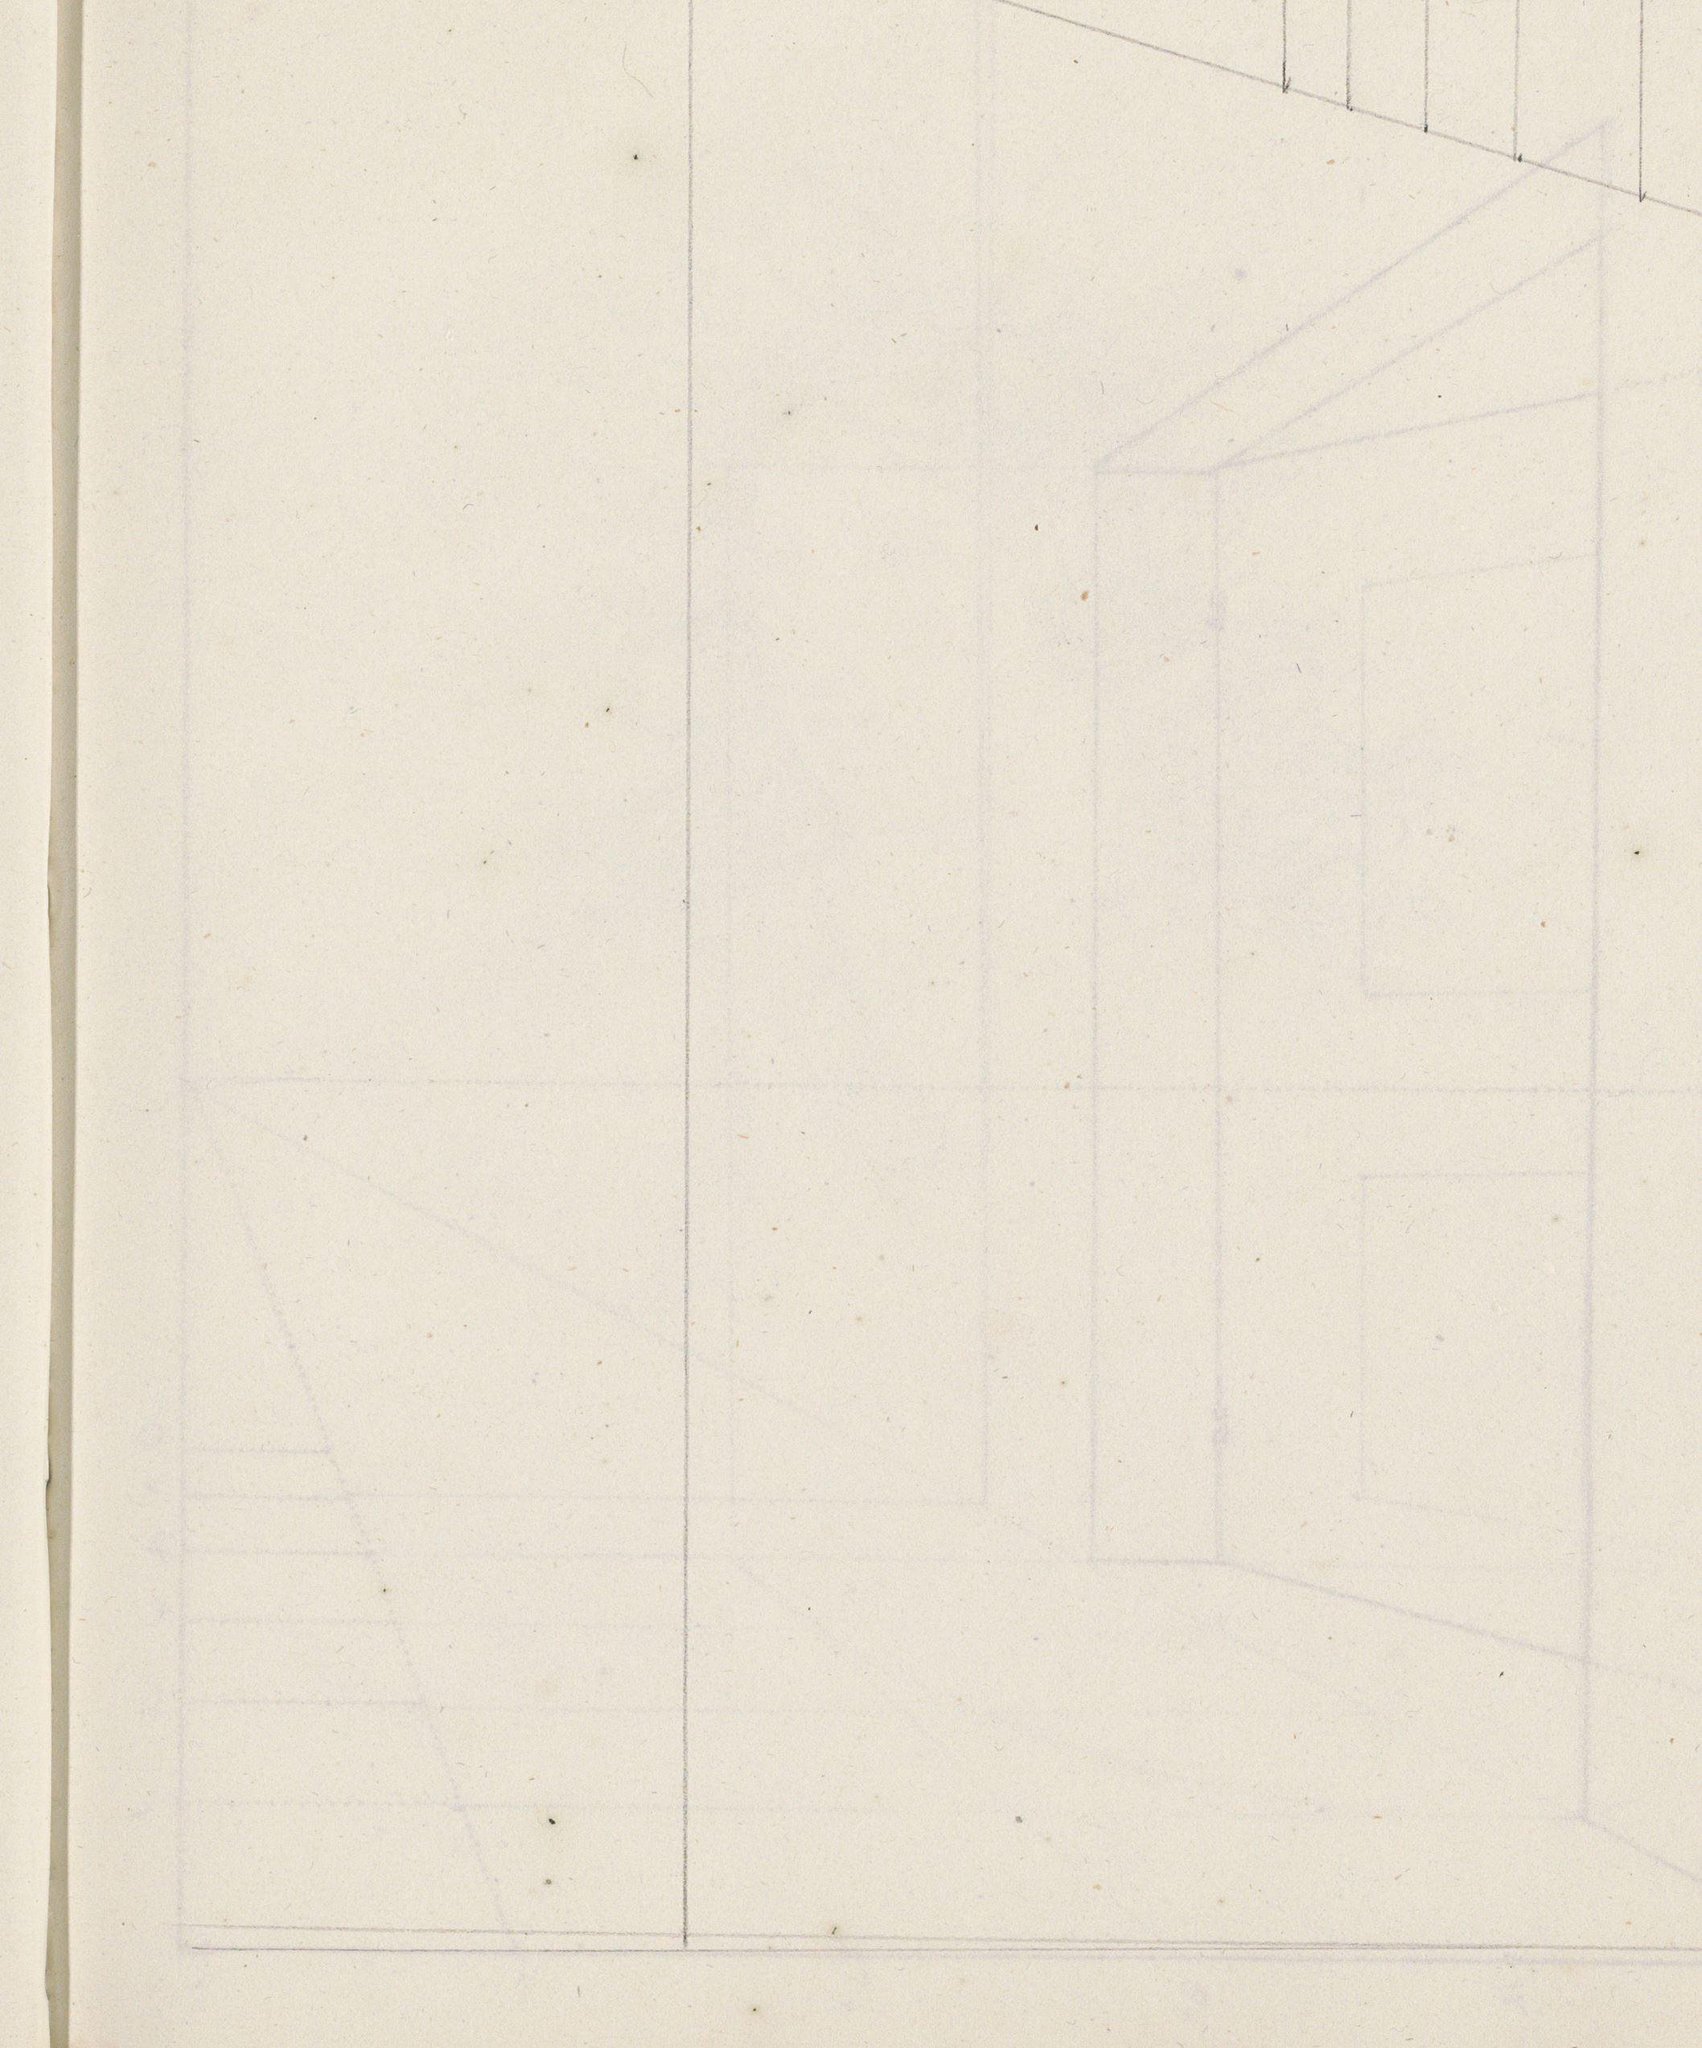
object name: sketchbook leaf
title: Perspectiefoefening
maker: jonkvrouw elisabeth kemper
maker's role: draughtsman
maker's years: 1799-1871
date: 1815-1852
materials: paper, pencil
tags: mathematical perspective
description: Blad 29 recto uit een schetsboek met 94 bladen.